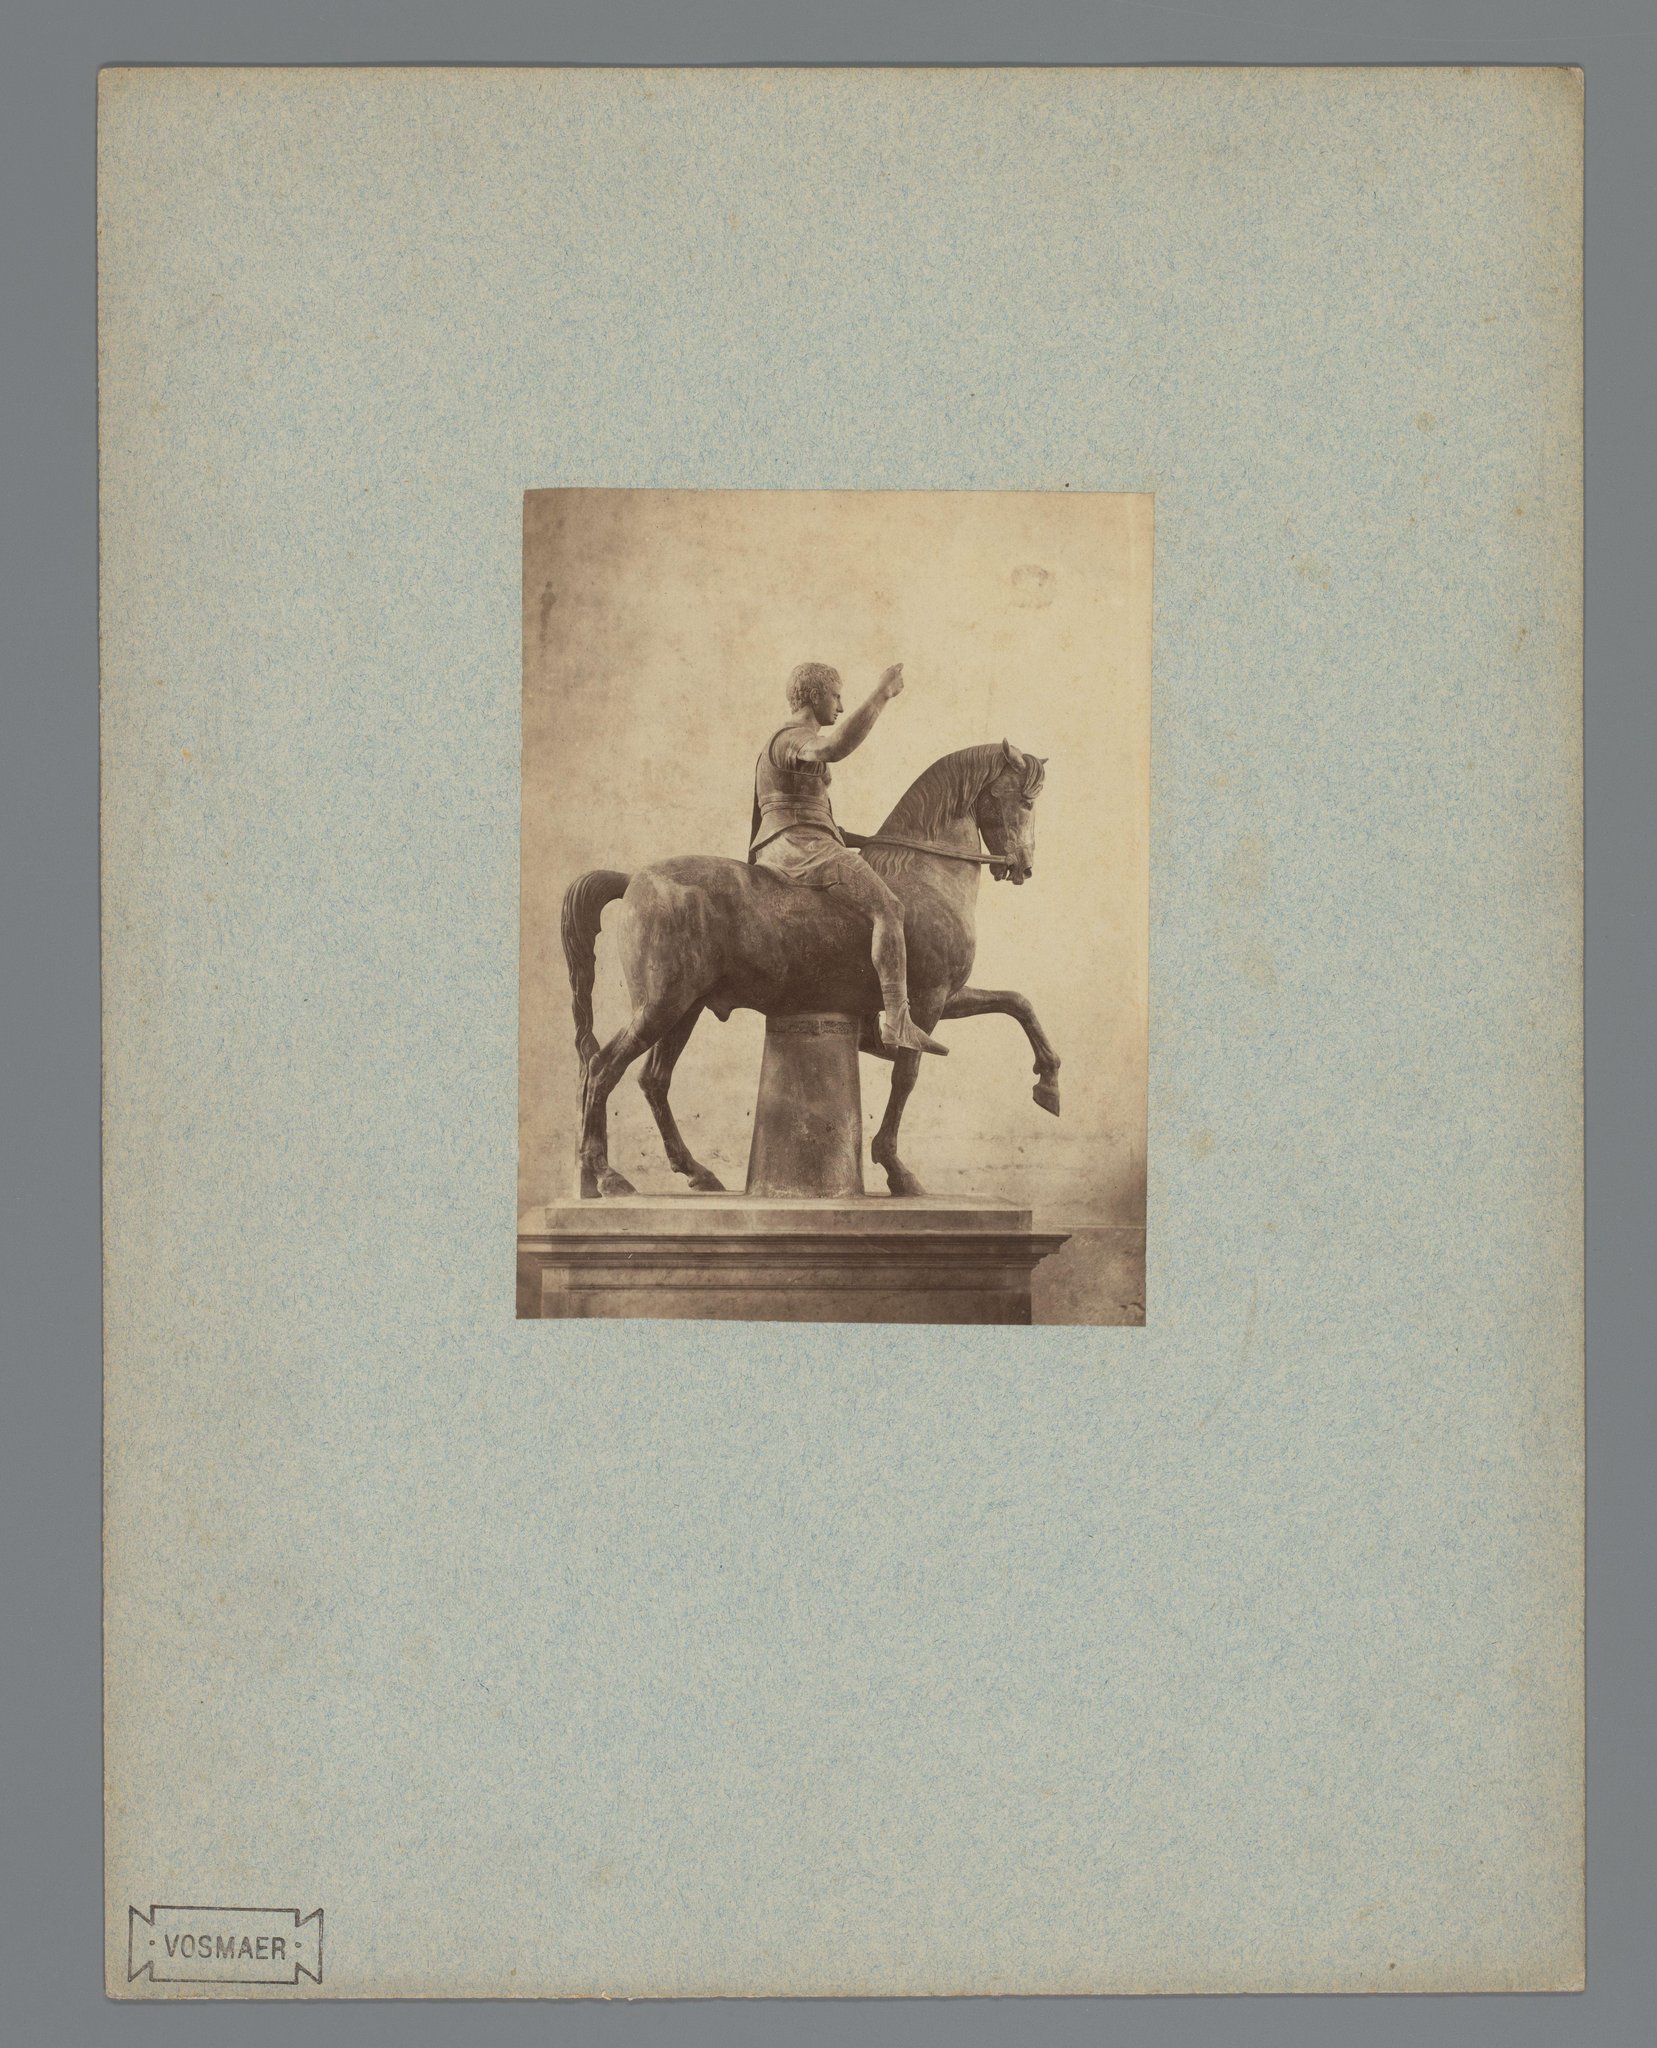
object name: photograph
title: Ruiterstandbeeld, mogelijk van een Romeinse keizer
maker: Anonymous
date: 1851-1890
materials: cardboard, paper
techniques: albumen print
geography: italy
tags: equestrian statue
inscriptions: collector's mark: ‘VOSMAER’